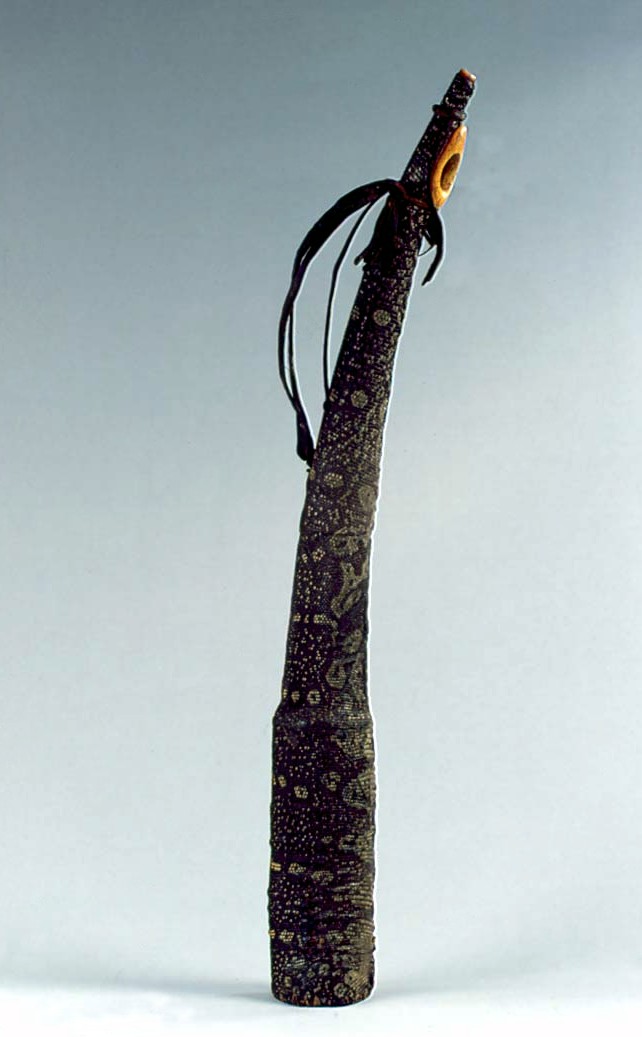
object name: horn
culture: mvuba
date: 1867-1900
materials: ivory, skin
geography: democratic republic of congo